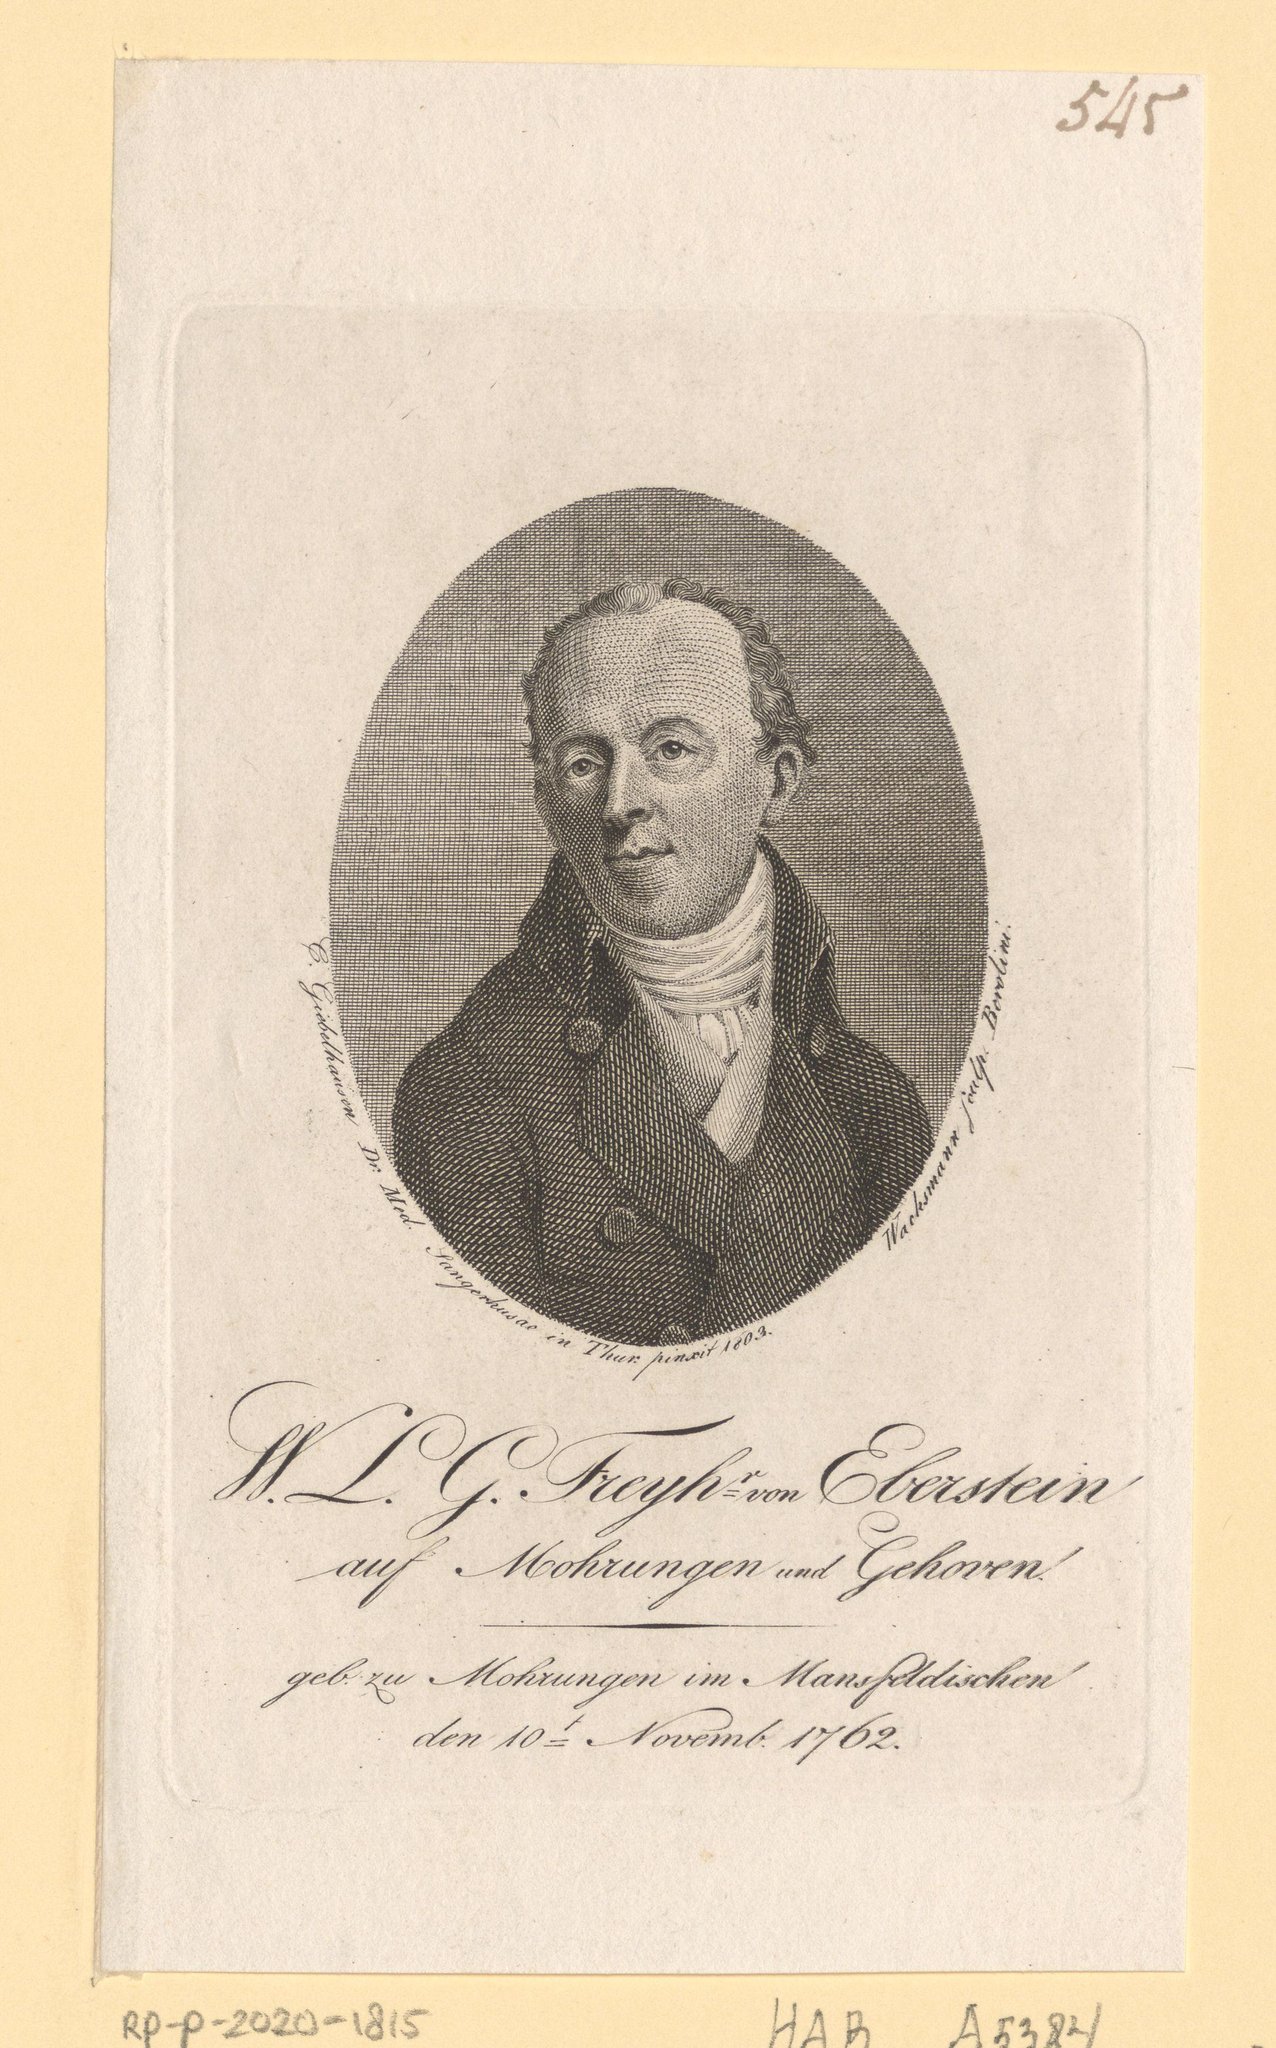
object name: print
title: Portret van Wilhelm Ludwig Gottlob Freiherr von Eberstein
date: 1803-1805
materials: paper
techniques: etching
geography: berlin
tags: historical persons